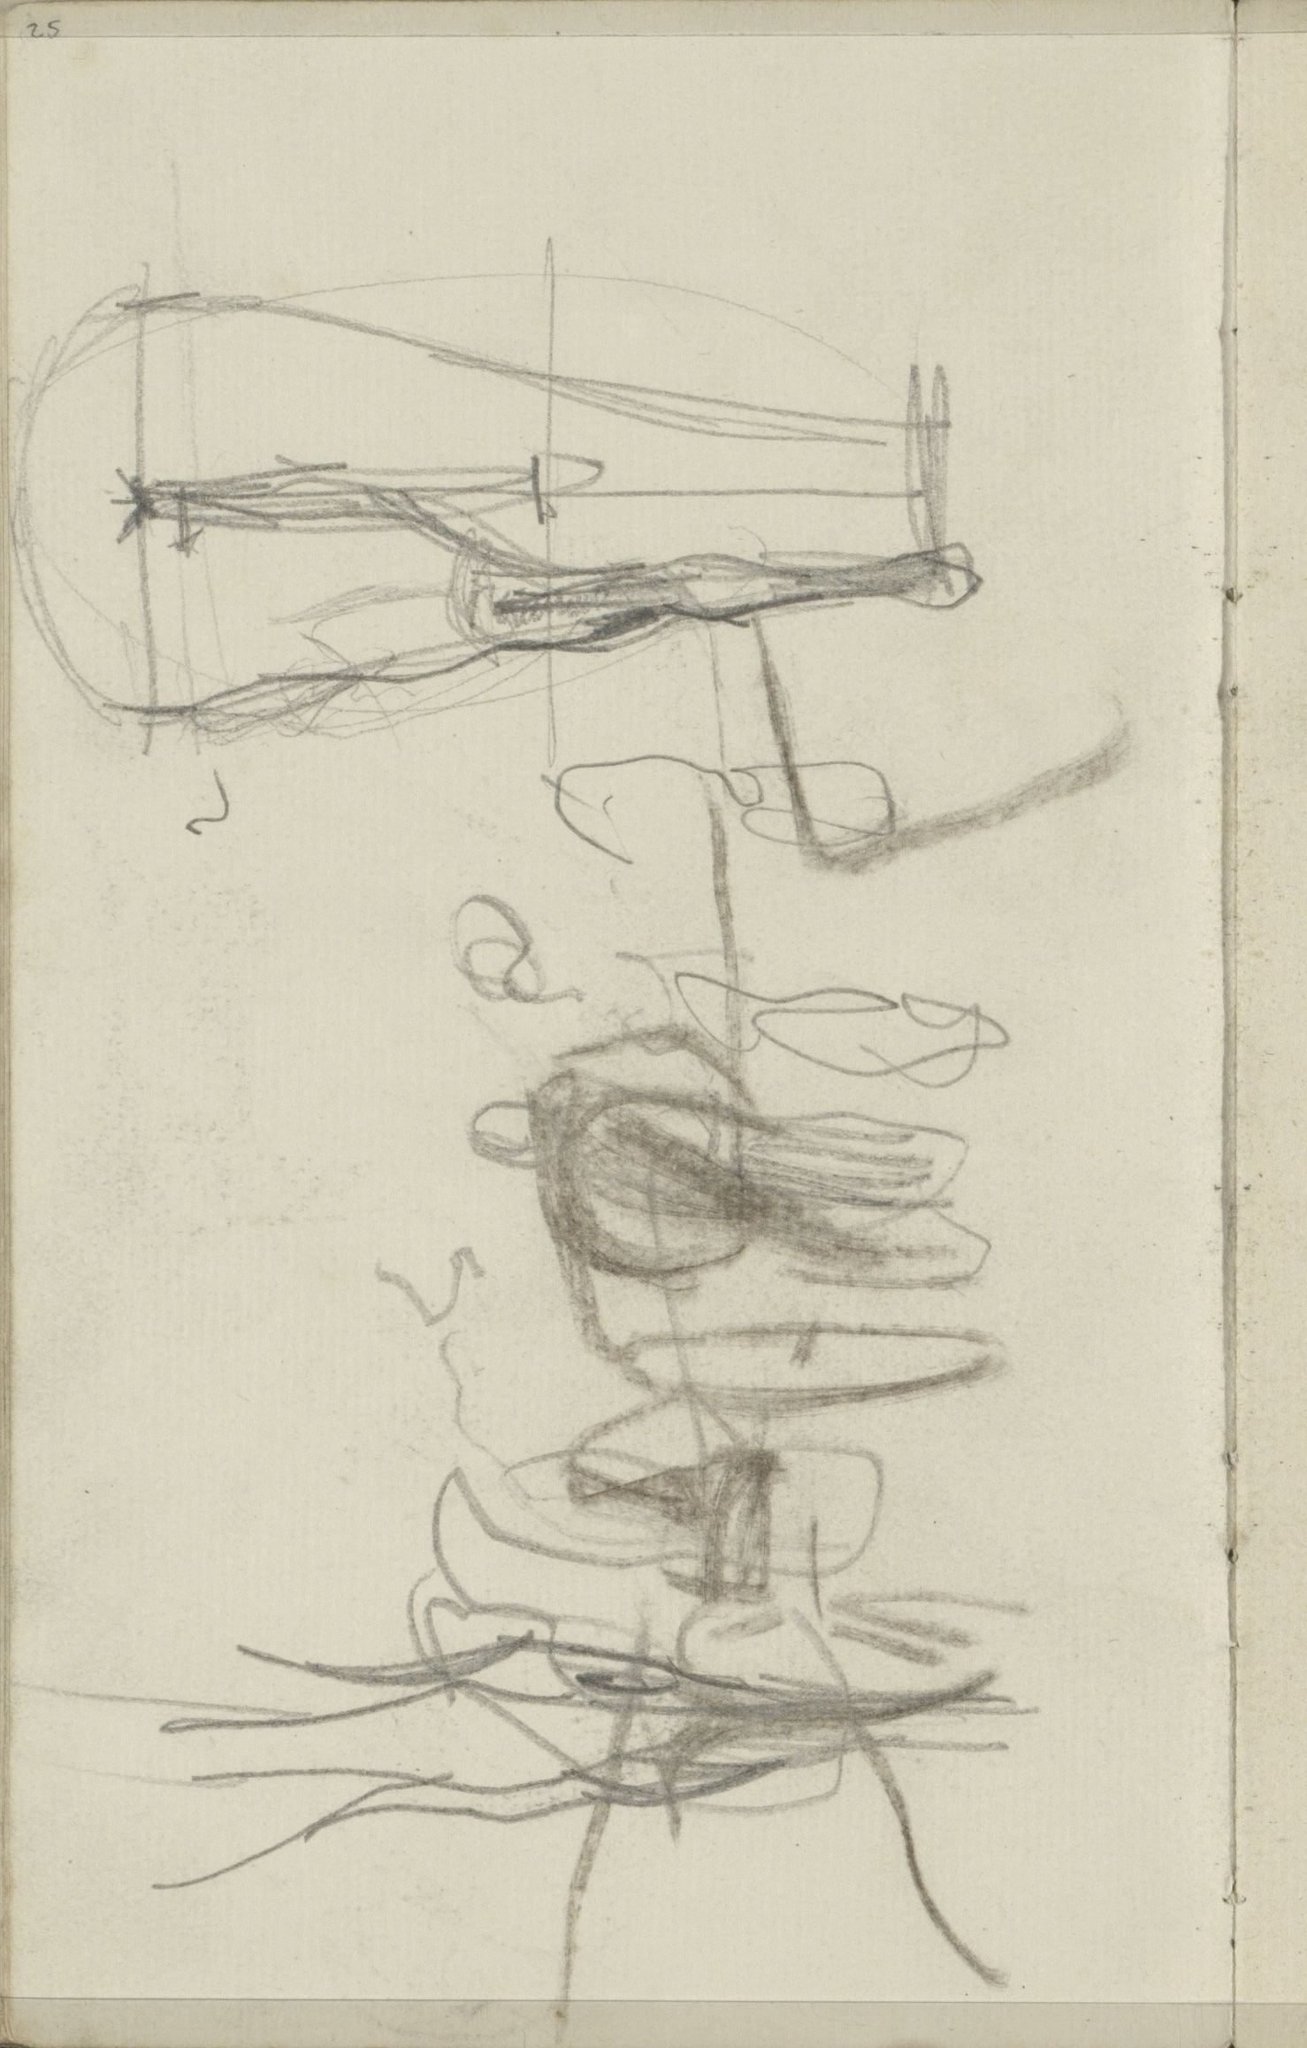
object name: sketchbook leaf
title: Paardenstudie en een figuur naast een paardenkar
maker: george hendrik breitner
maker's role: draughtsman, painter, print maker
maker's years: 1857-1923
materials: chalk, paper, pencil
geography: the hague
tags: two-wheeled, animal-drawn vehicle, adult man, horse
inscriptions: kleurnotitie, handgeschreven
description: Pagina 25 uit een schetsboek met 28 bladen.